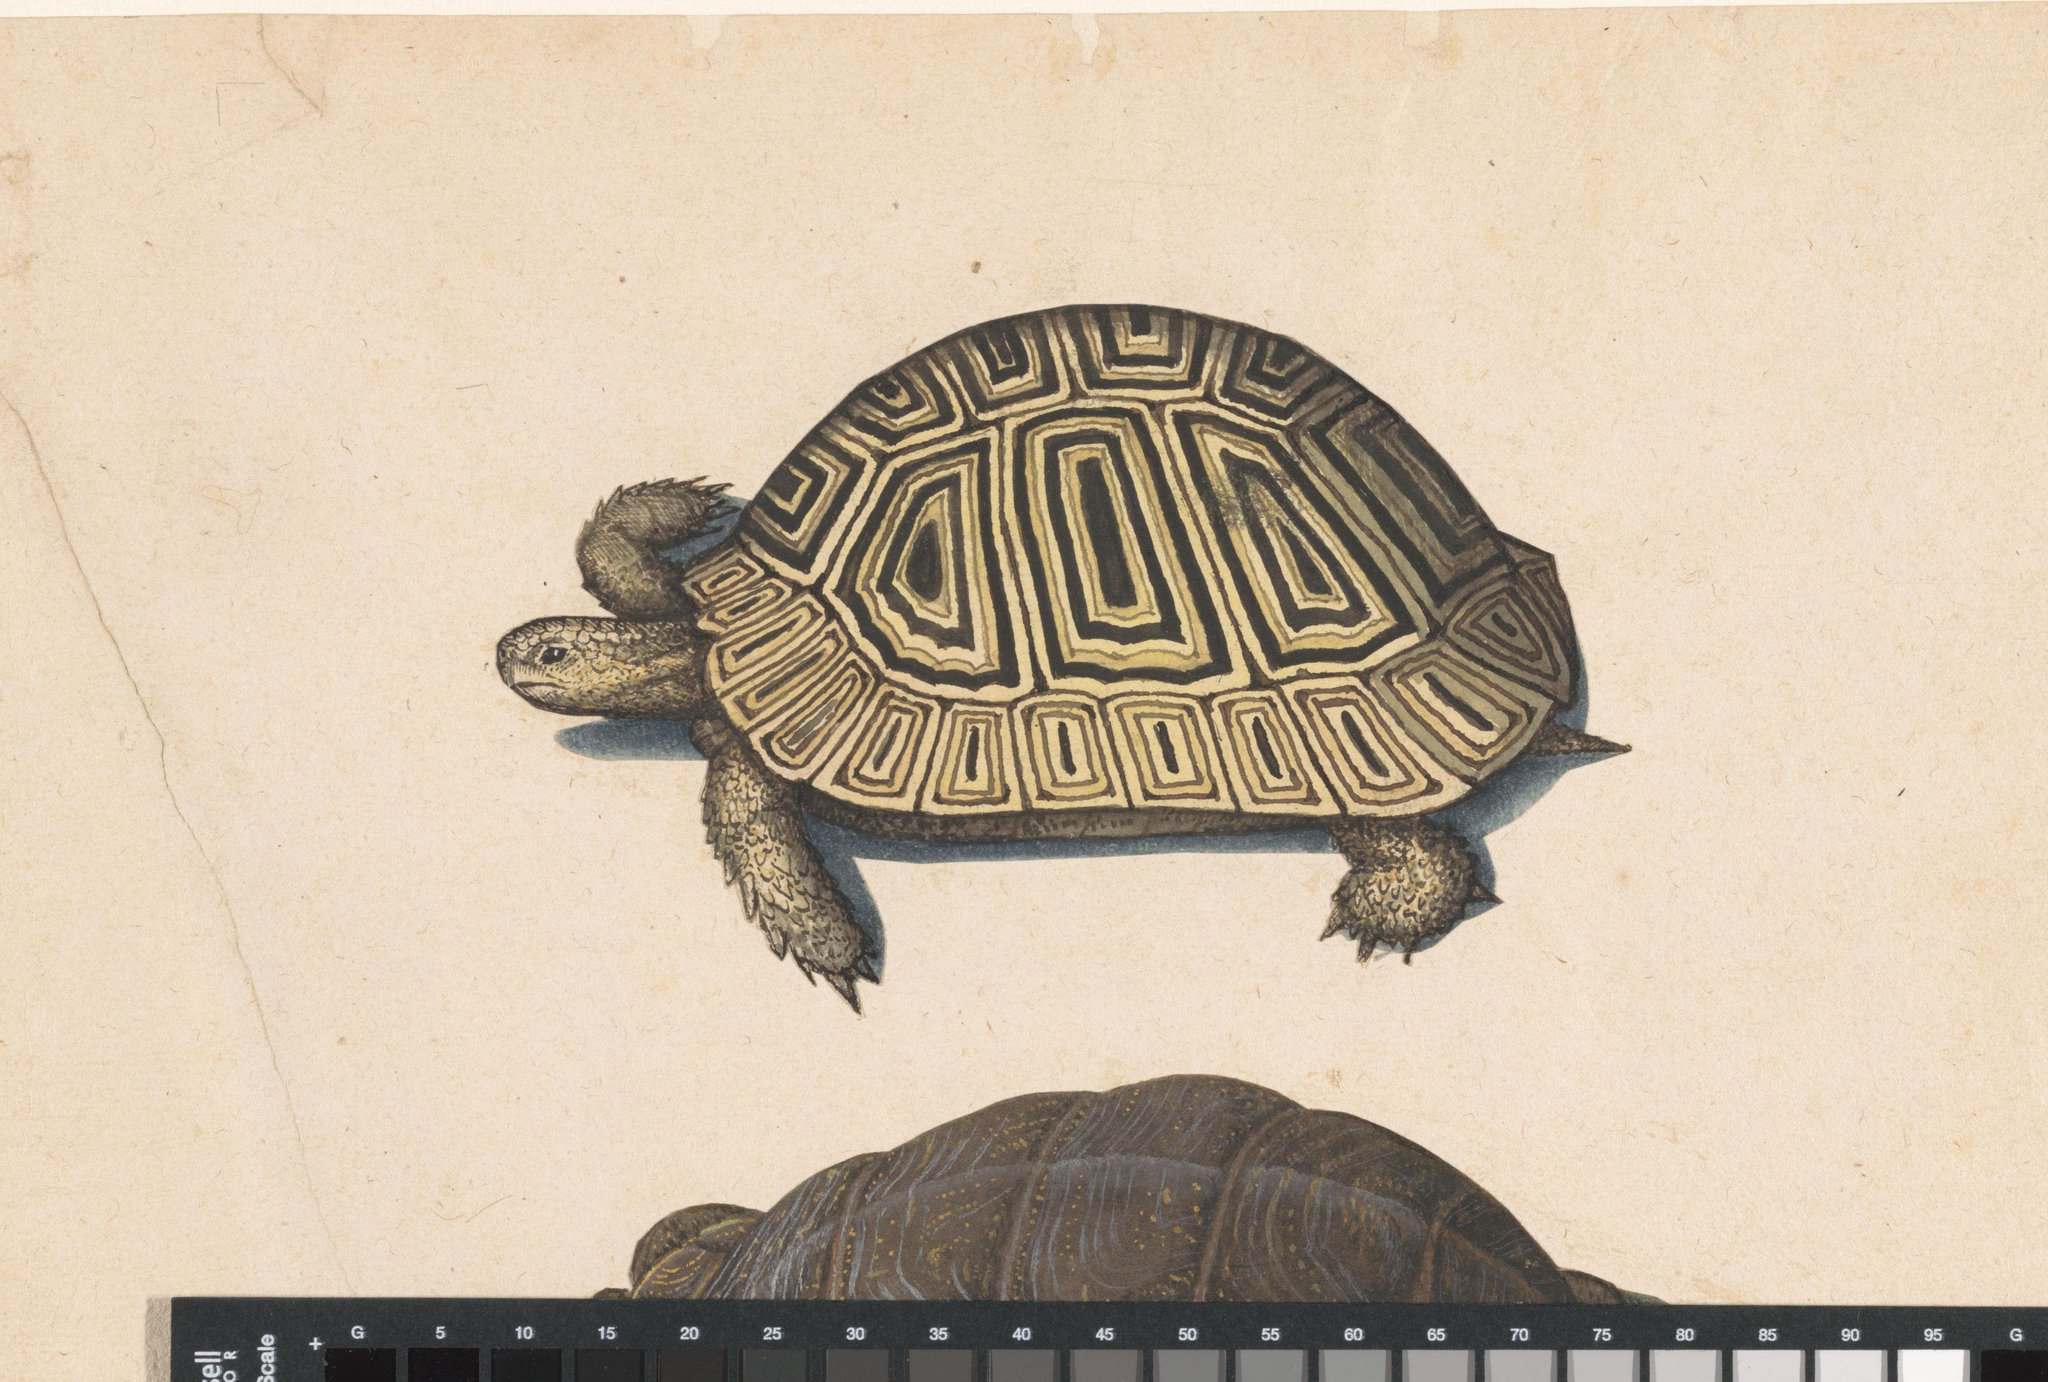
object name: drawing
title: Lombard album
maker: Anonymous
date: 1560-1585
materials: ink, paper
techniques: brush, pen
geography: low countries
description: Een landschildpad, mogelijk de Moorse landschildpad (testudo graeca).